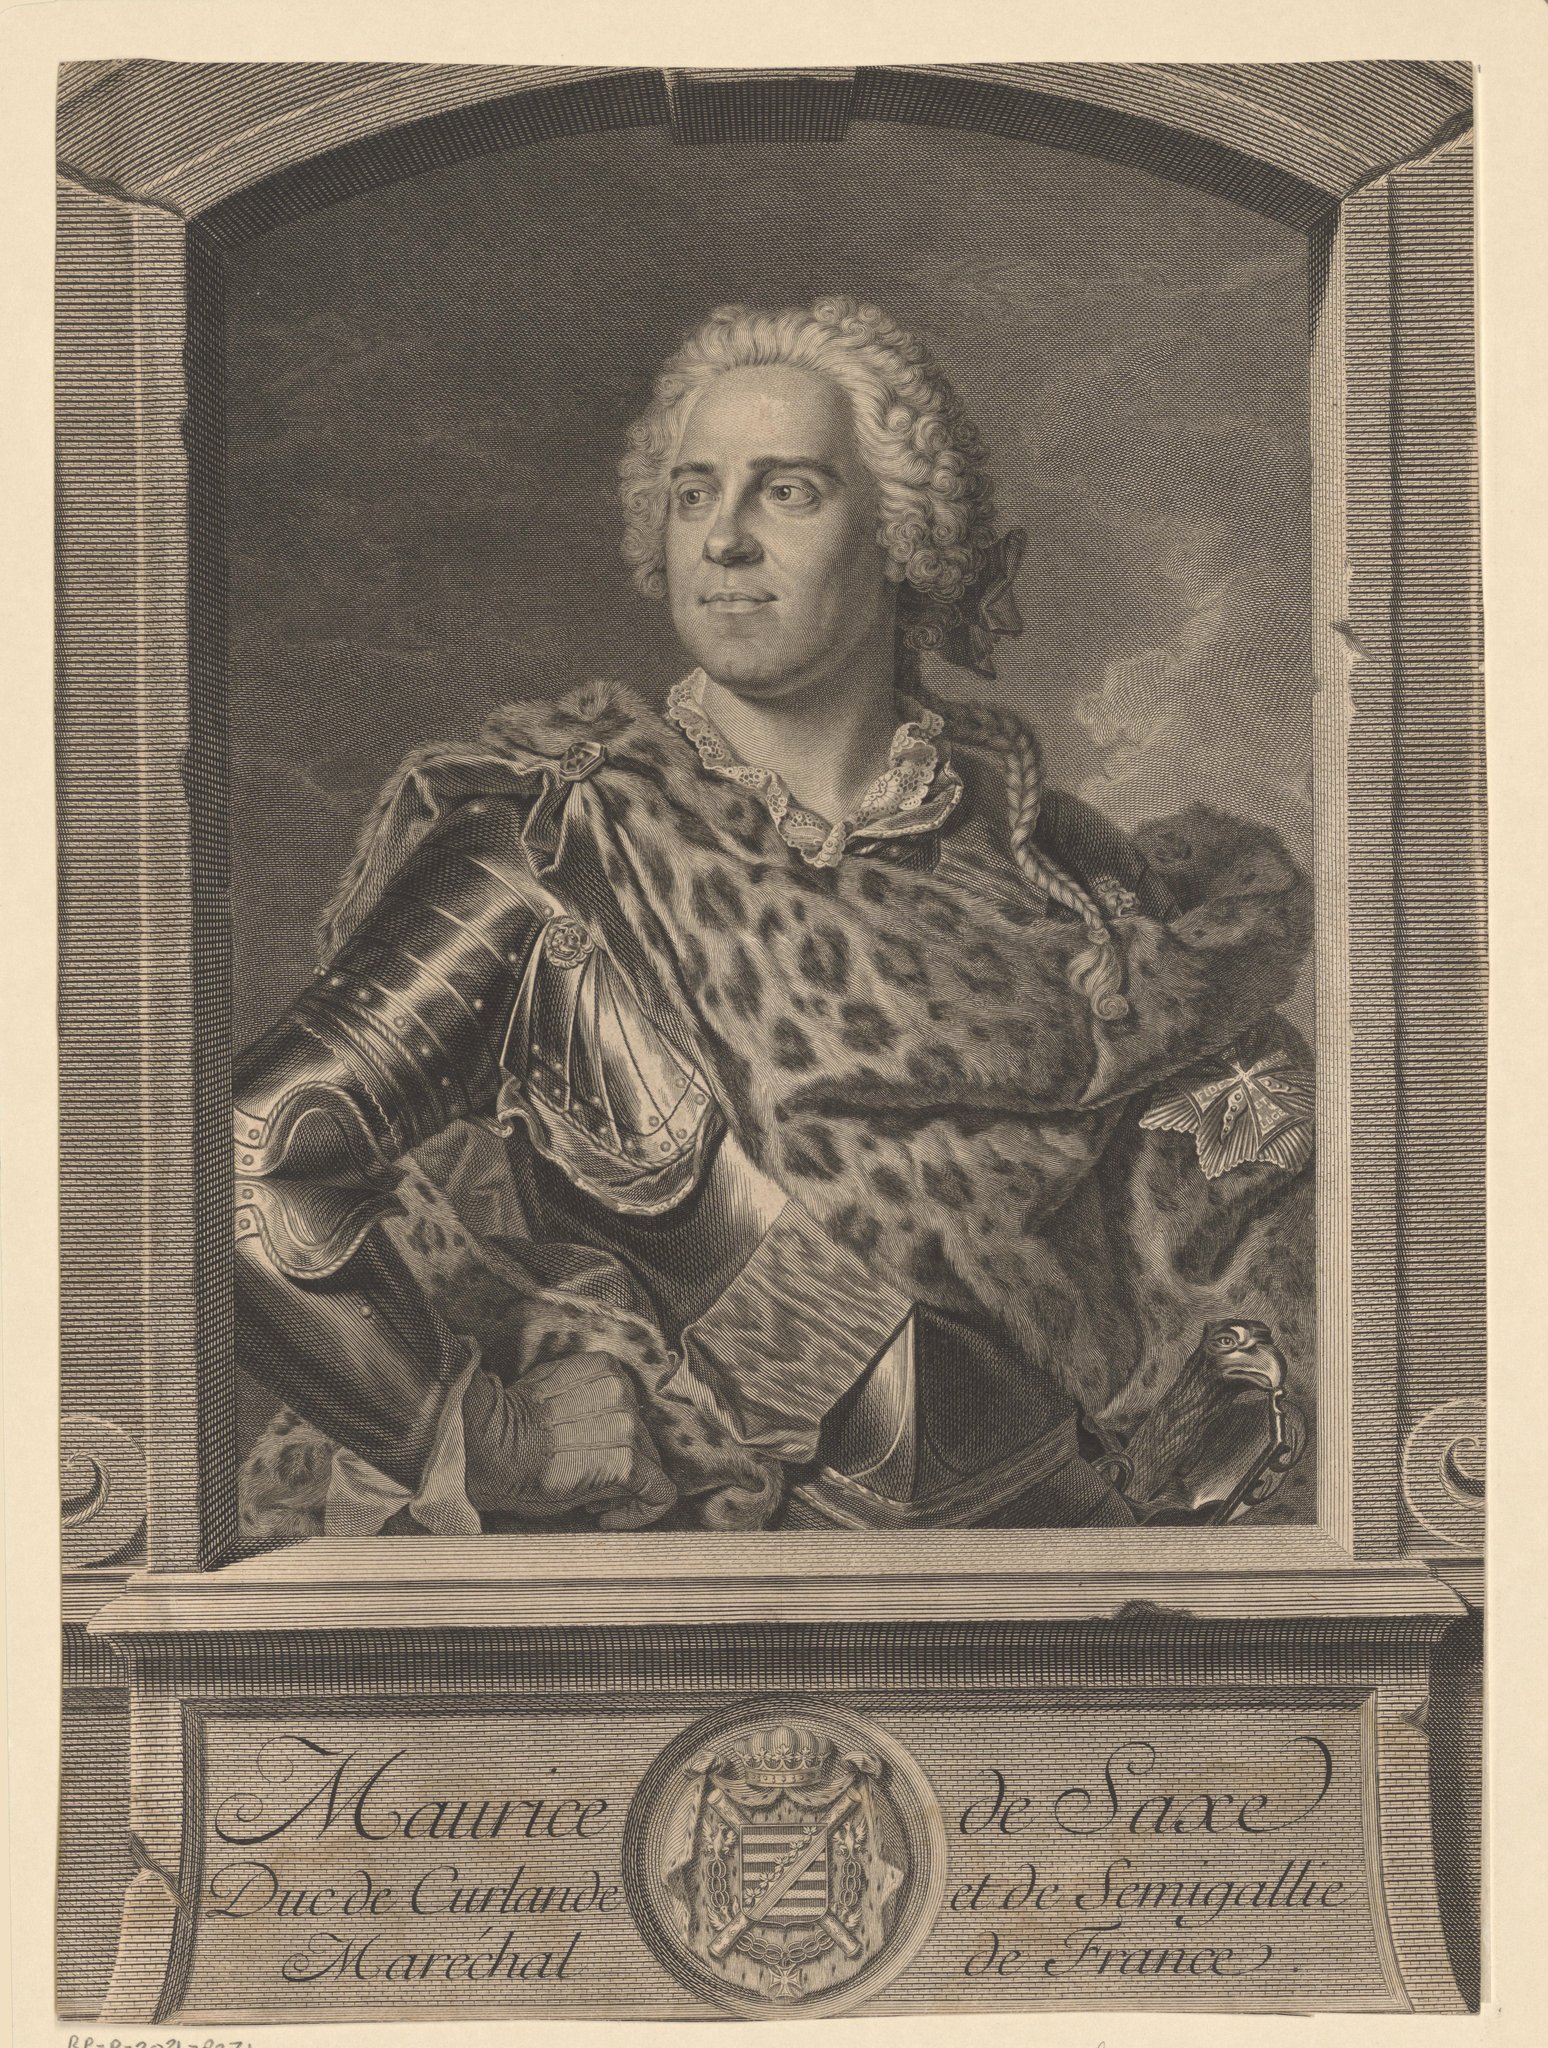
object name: print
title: Portret van Maurits van Saksen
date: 1745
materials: paper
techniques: engraving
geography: paris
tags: commander-in-chief, general, marshal, historical persons, armorial bearing, heraldry